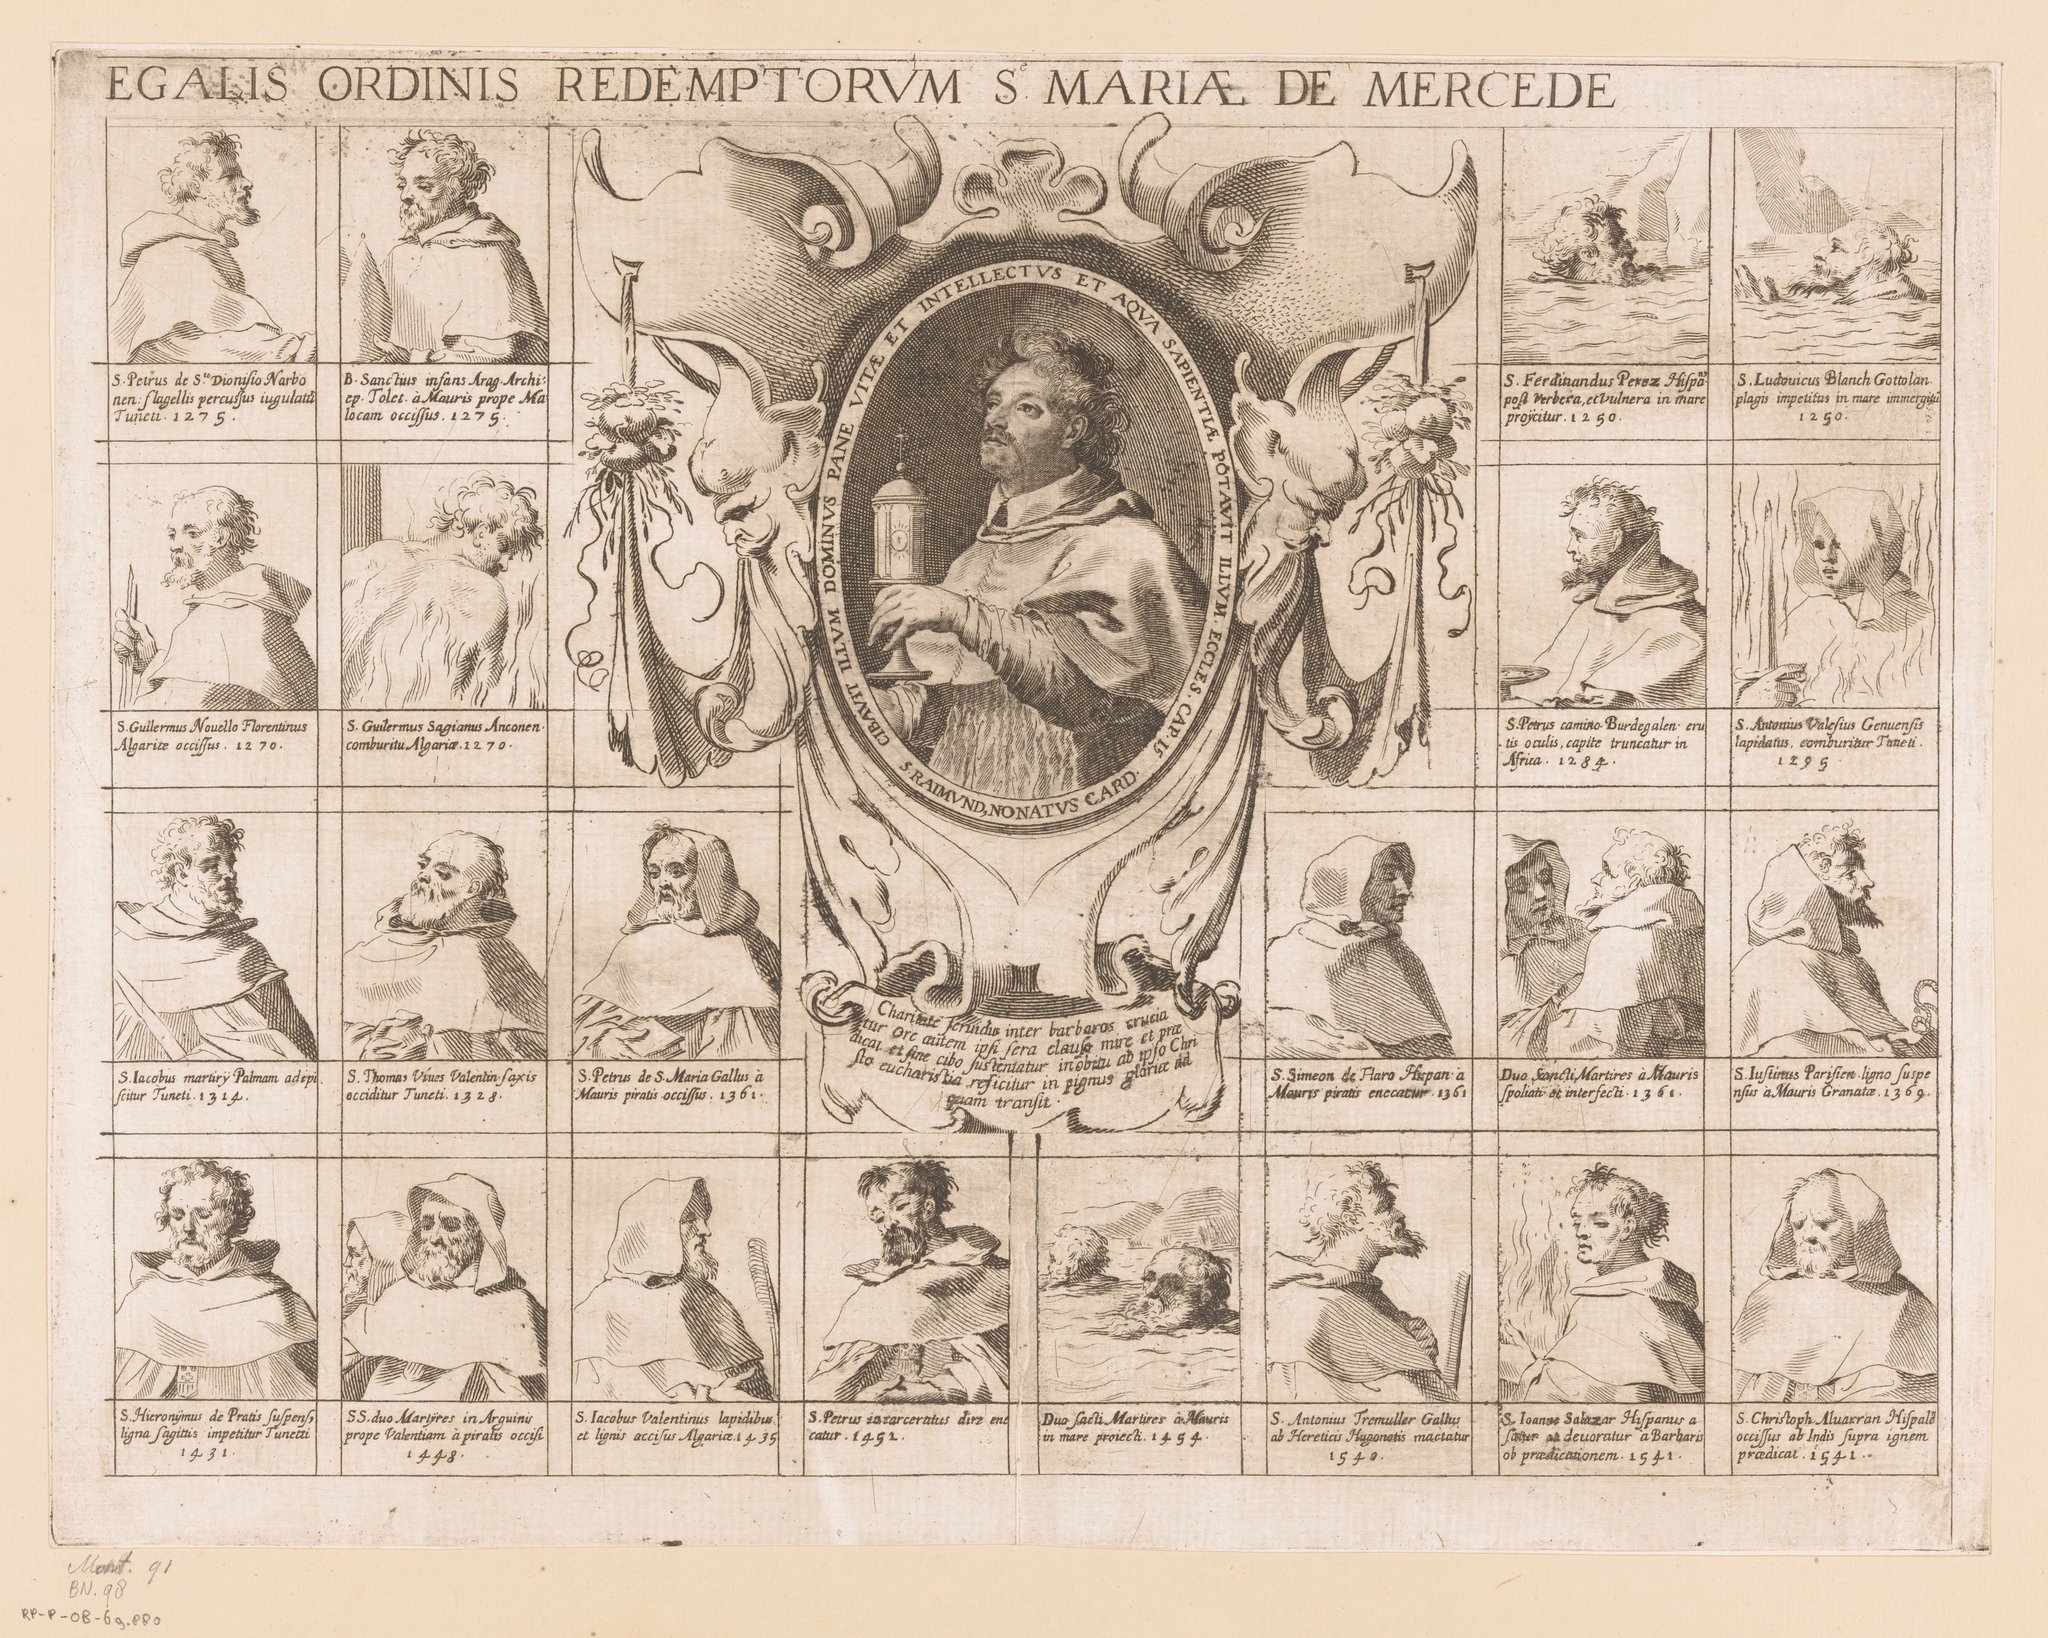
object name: print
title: Centuria Sanctorum Martyrum Et Confessorum Regalis Ordinis Redemptorum S. Maria De Mercede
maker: claude mellan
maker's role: draughtsman, print maker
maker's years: 1598-1688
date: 1624-1636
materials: paper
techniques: engraving, etching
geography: rome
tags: saints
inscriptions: collector's mark: Lugt 240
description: Plaat rechtsboven van geheel bestaande uit vier platen met 98 martelaren van de Orde van Notre-Dame-de-la-Merci, ook wel Mercedariërs genoemd, met twee portretten van Peter Nolasco en Raymundus Nonnatus in ovalen.